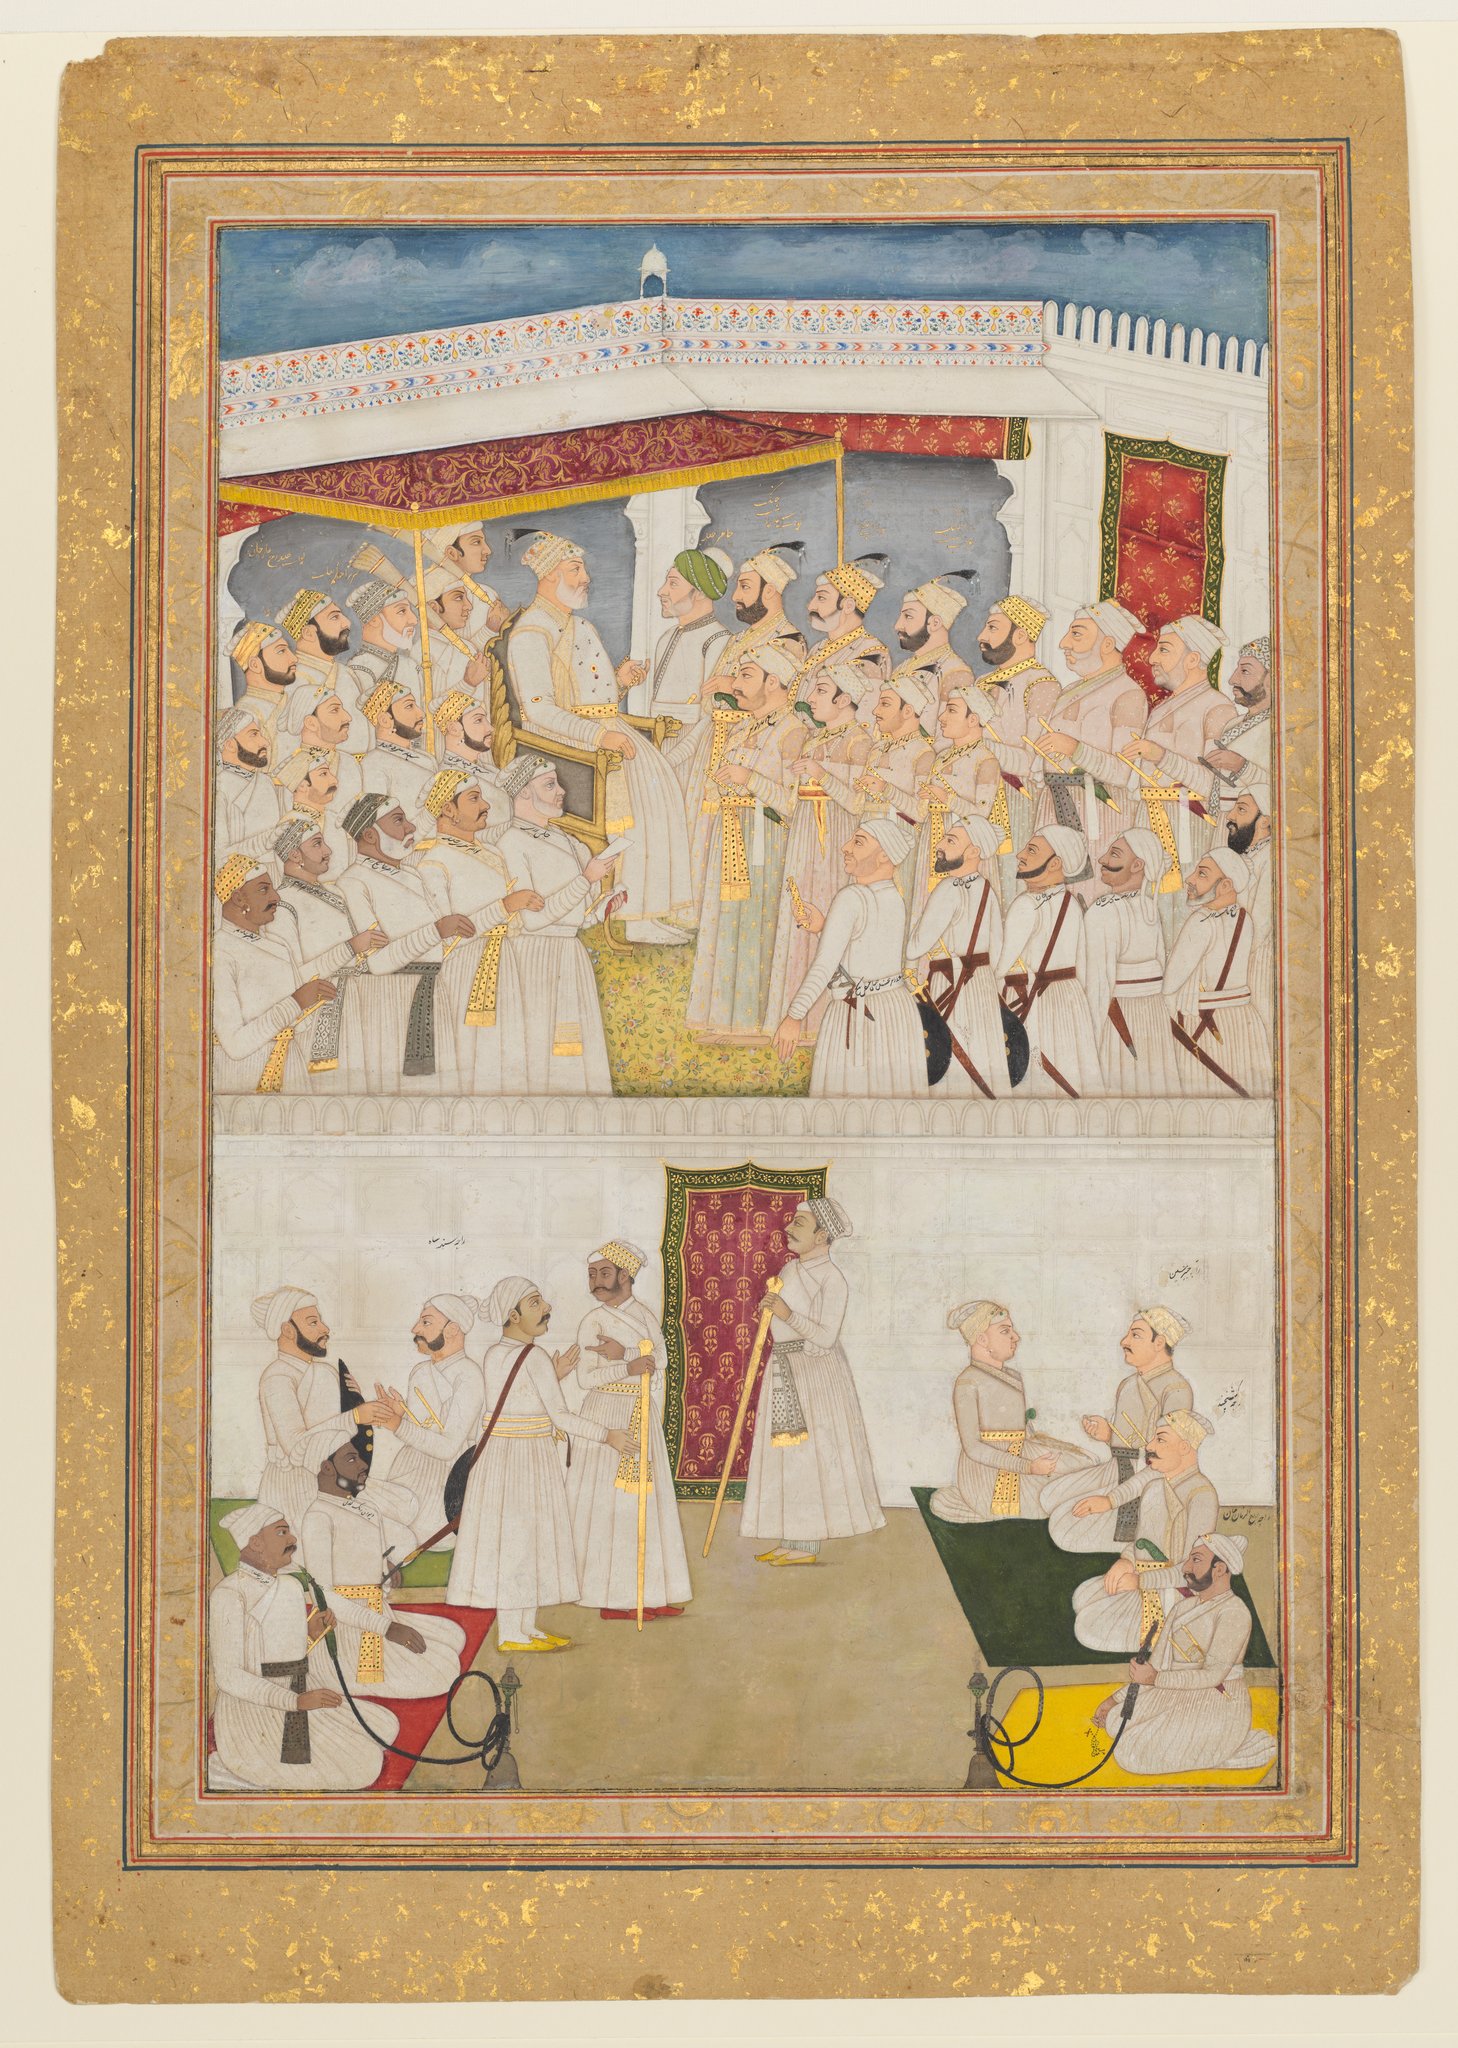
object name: illustrated single work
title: Darbar of Alivardi Khan at Murshidabad's Court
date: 1750-1753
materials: gold, paper, pigment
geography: india